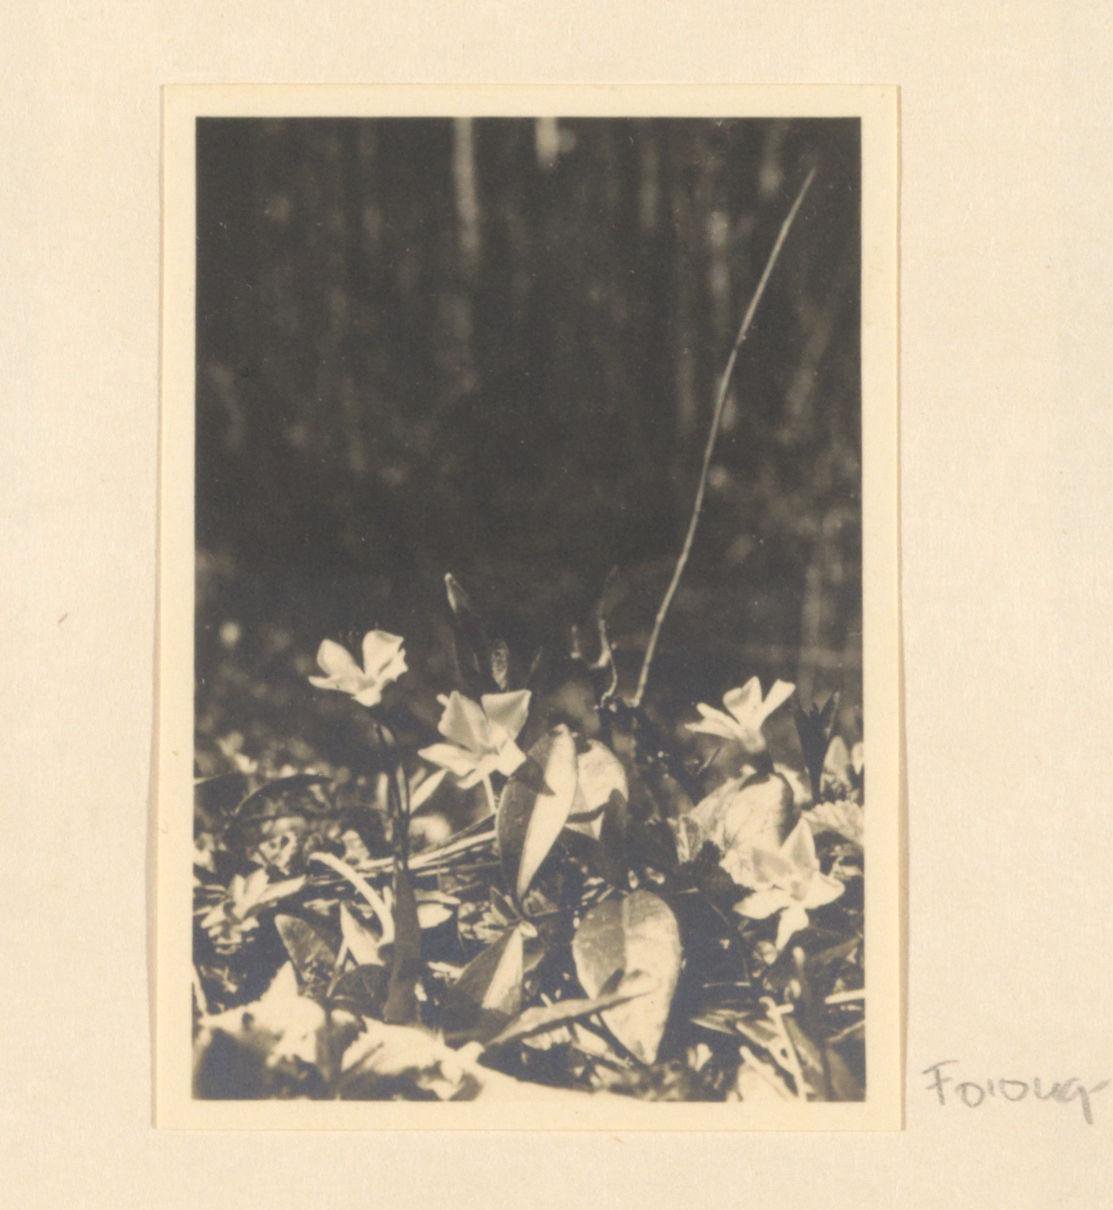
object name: photograph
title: Bloemen in het wild, vermoedelijk in de buurt van Schule Schloss Salem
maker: Anonymous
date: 1929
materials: photographic support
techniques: gelatin silver print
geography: salem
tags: flowers, education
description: Onderdeel van Fotoalbum van Schule Schloss Salem.